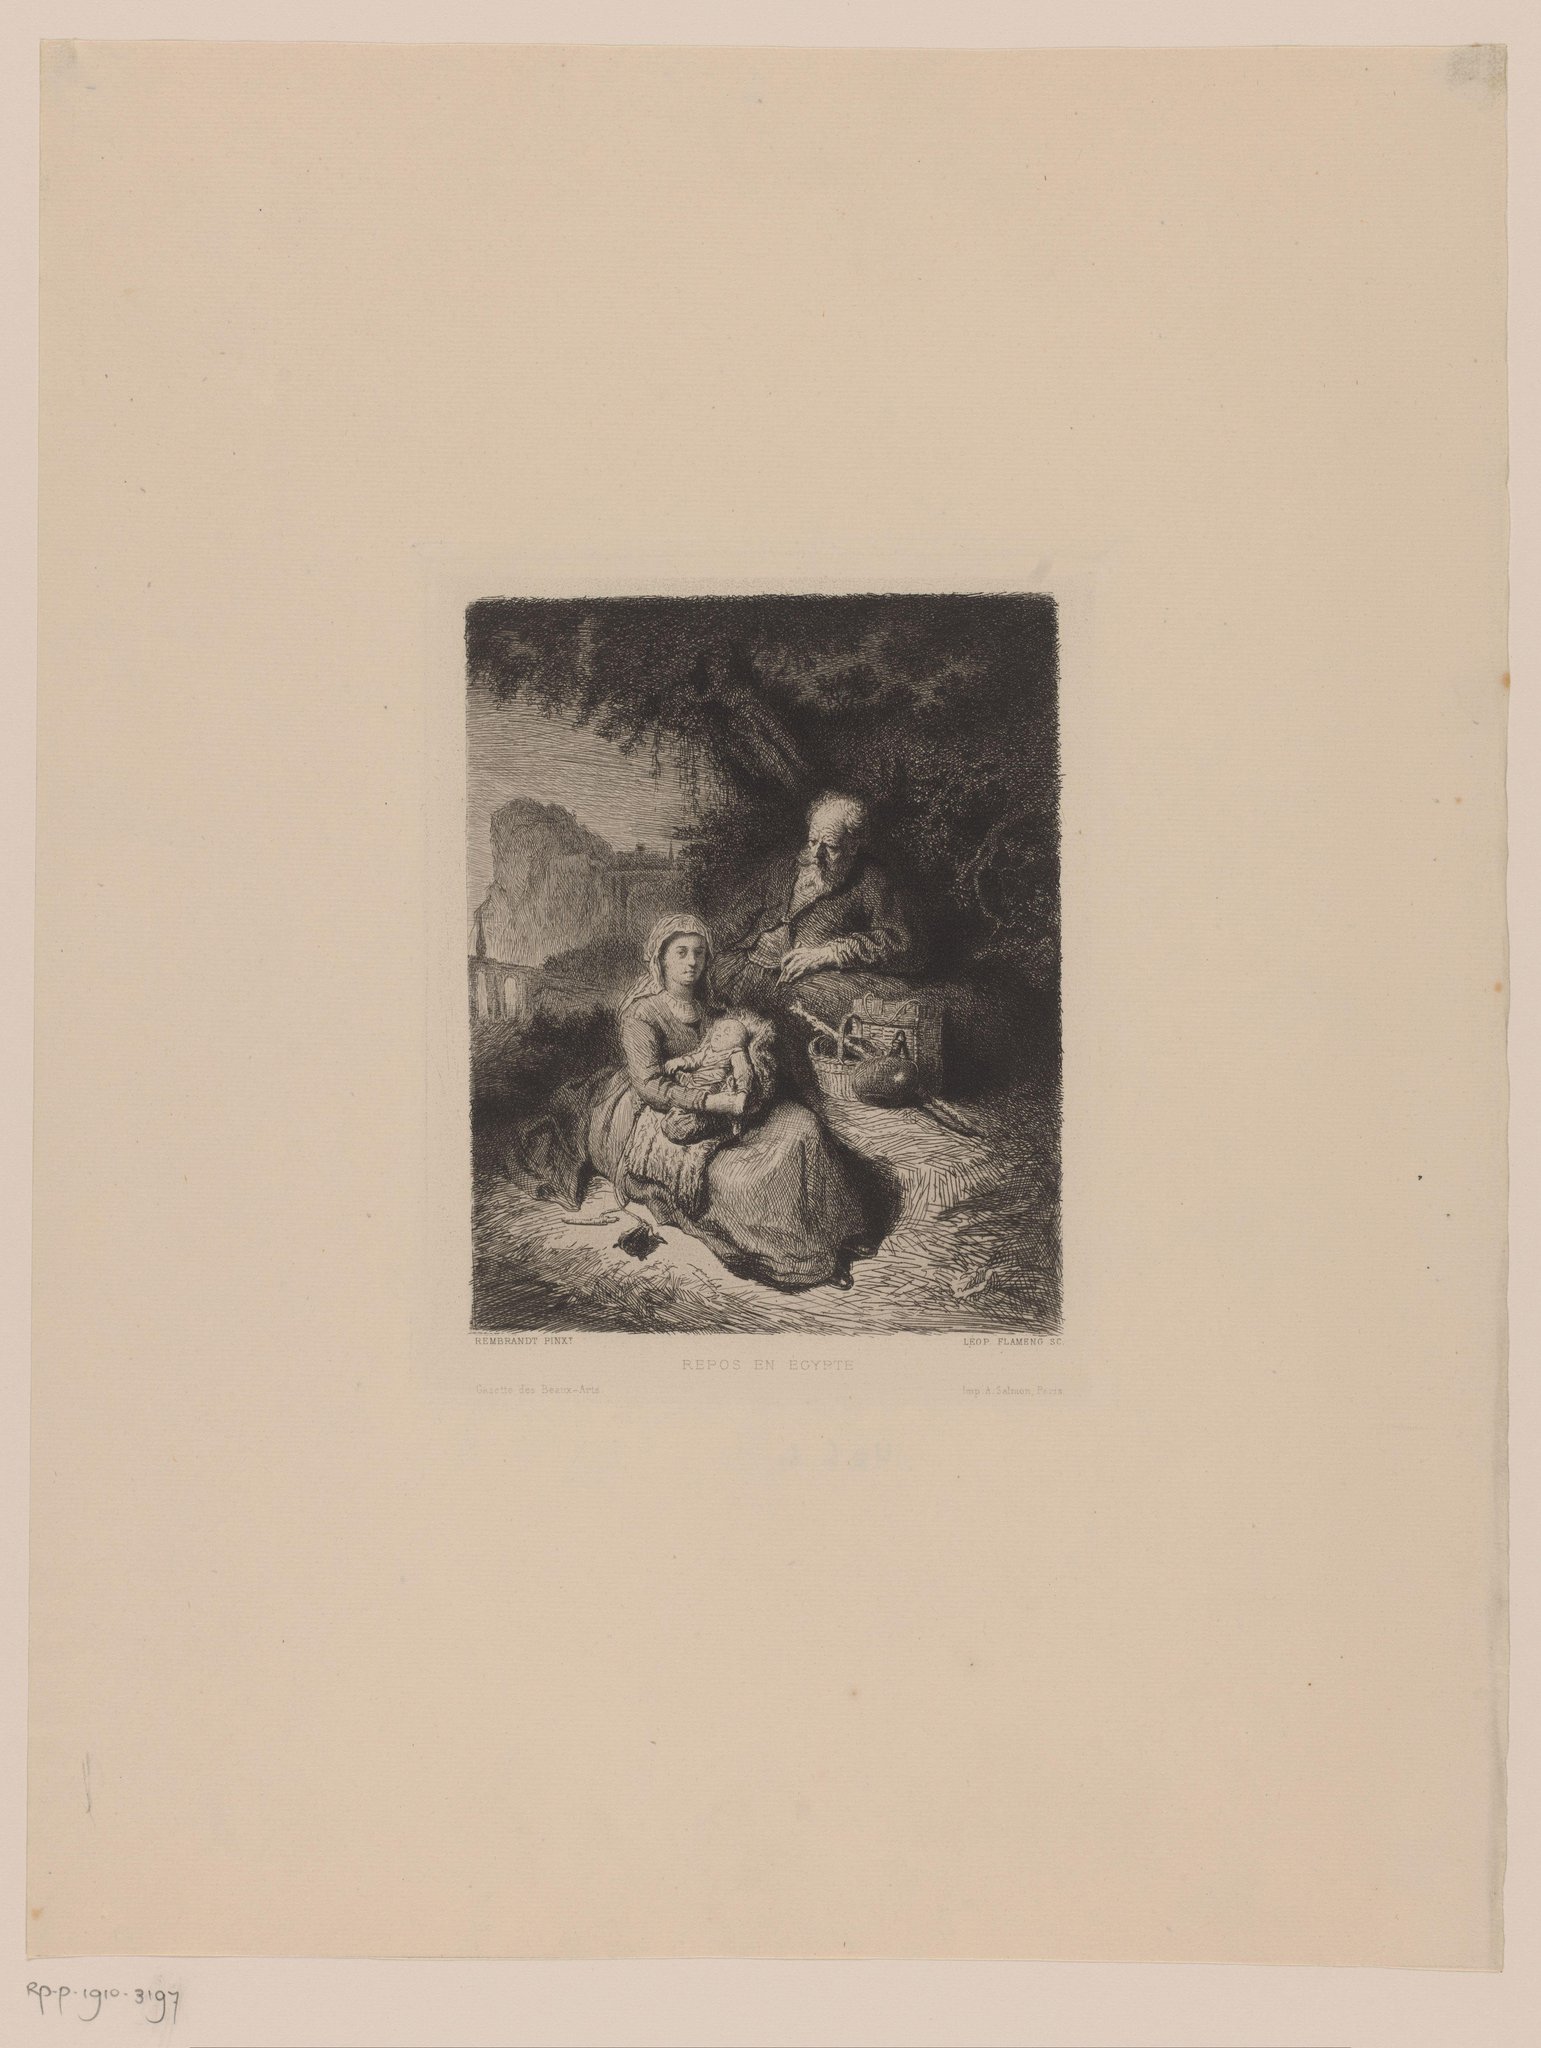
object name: print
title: Rest on the Flight into Egypt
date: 1874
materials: paper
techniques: etching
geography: paris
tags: rest on the flight into egypt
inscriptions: collector's mark: Lugt 2228